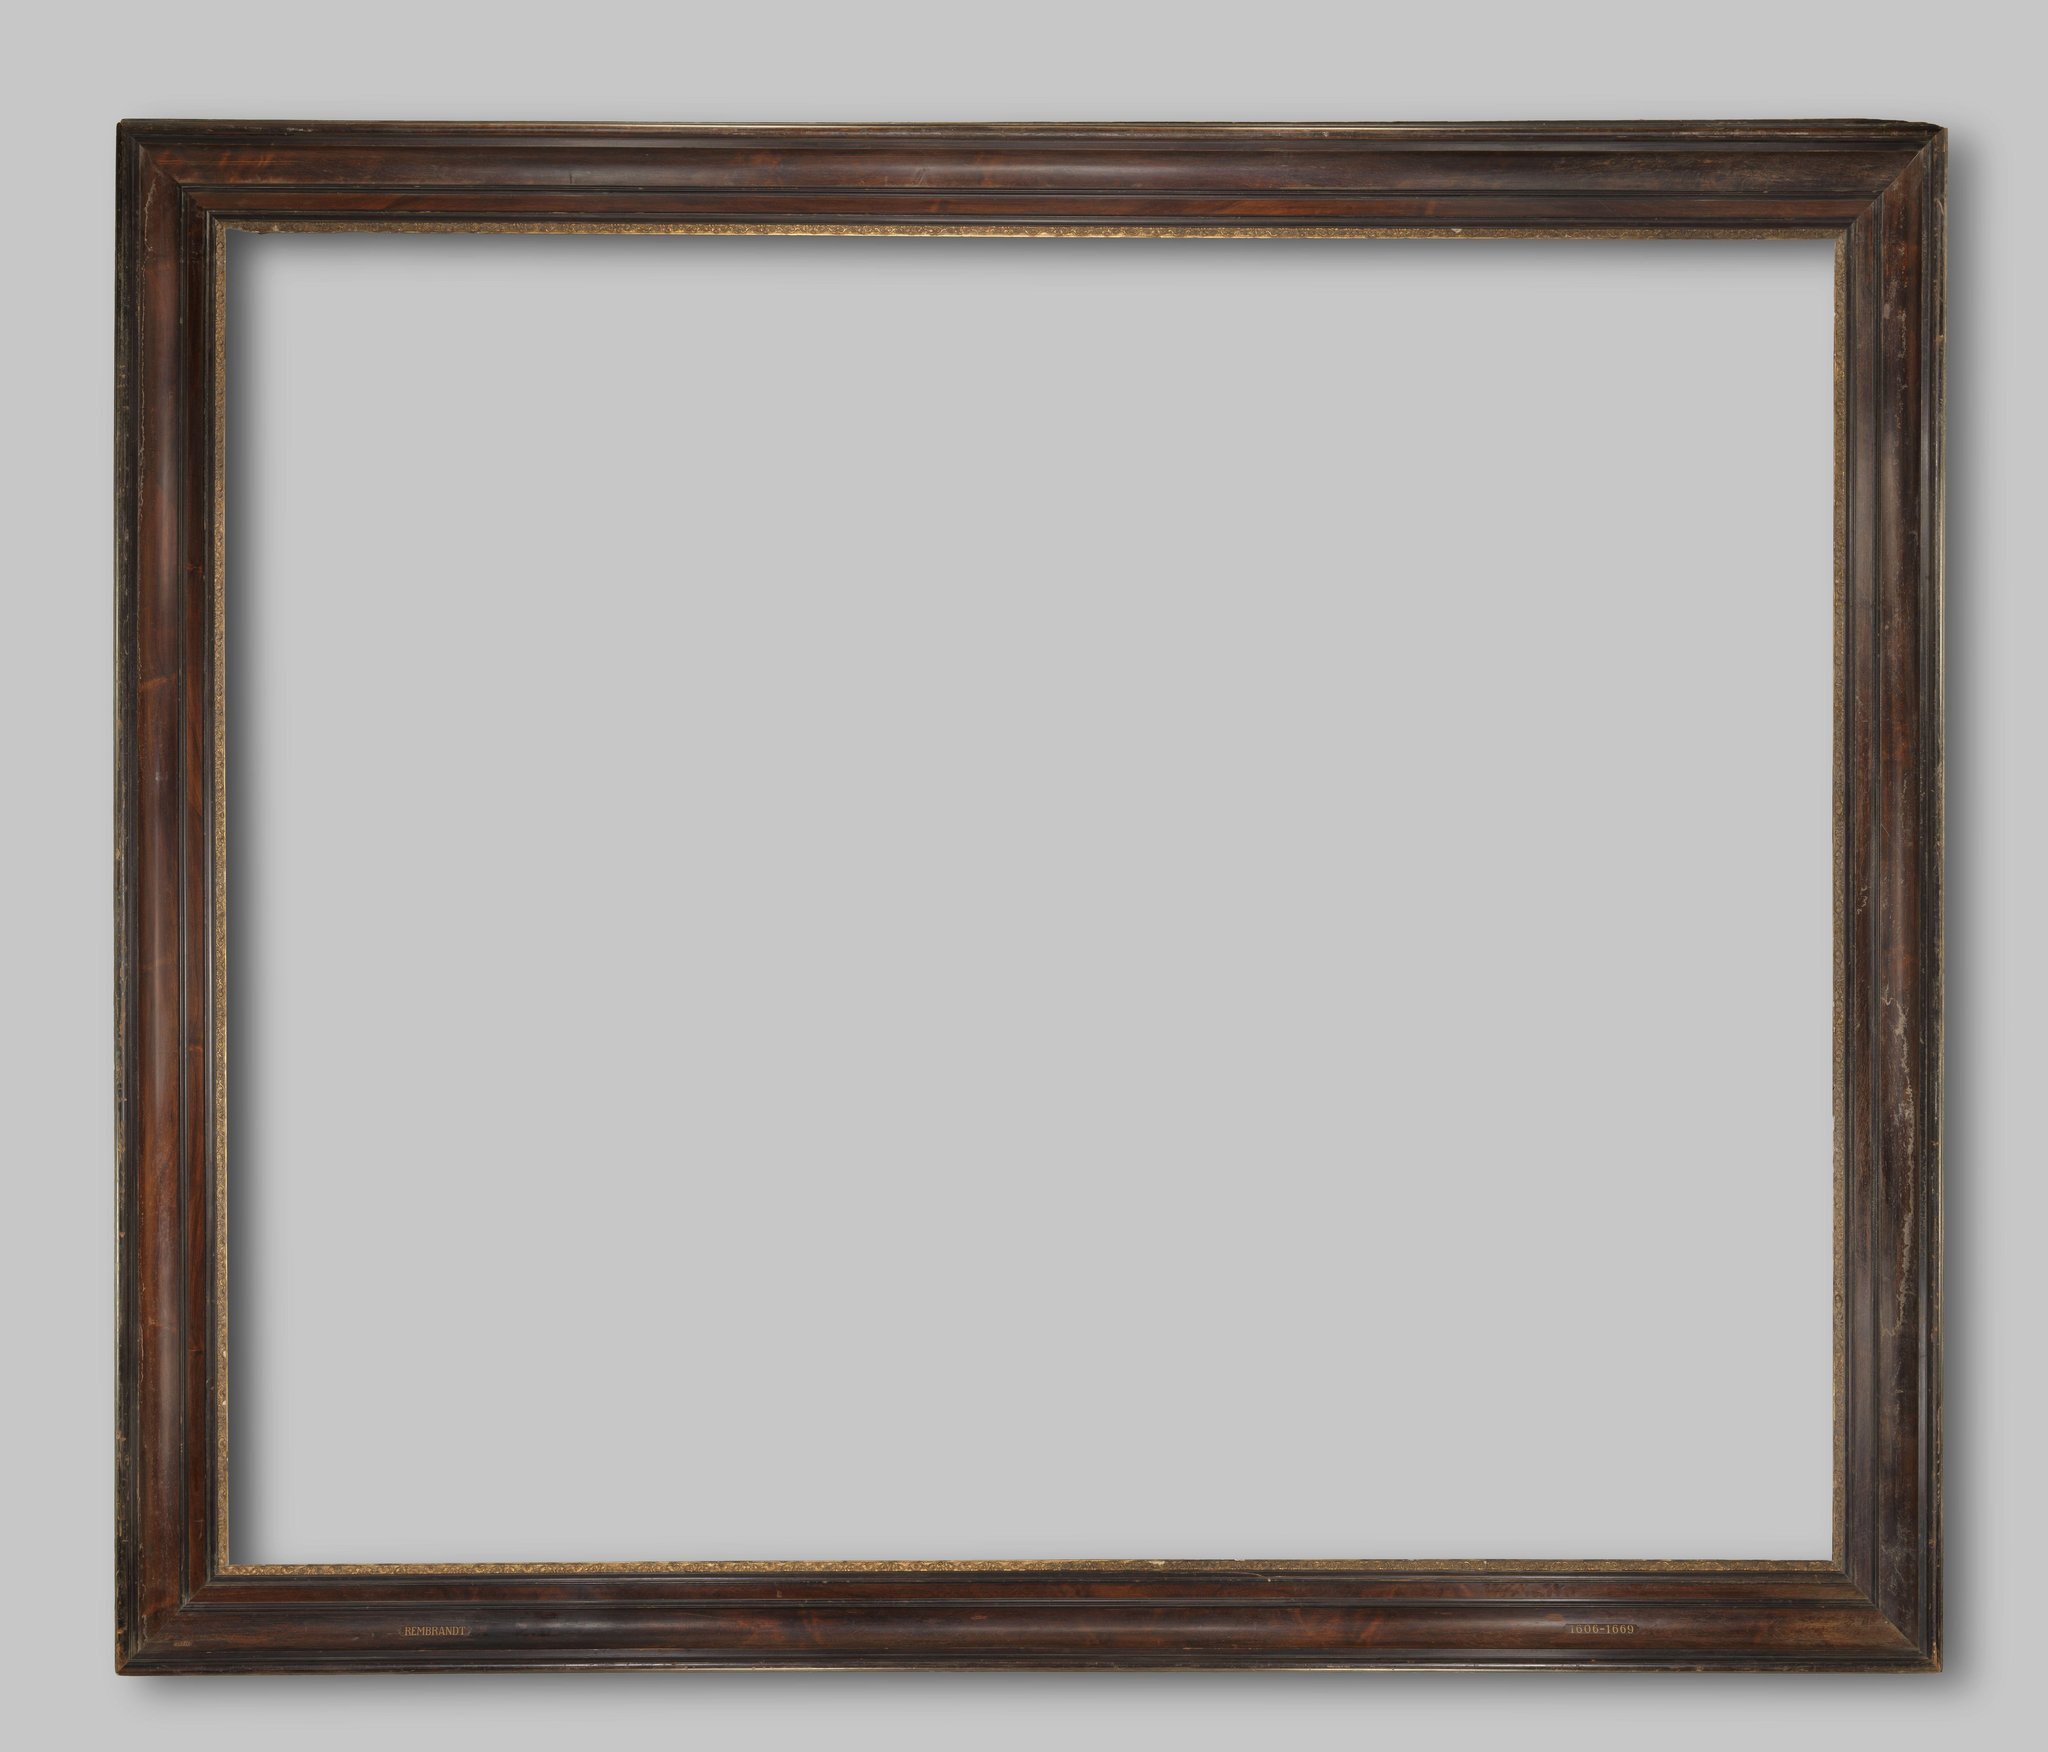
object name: frame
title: Bruine gebeitste profiellijst met vergulde binnenrand met pâte-ornamenten, 4 afzonderlijk genummerde delen.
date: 1600-1999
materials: gold leaf, wood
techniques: gilding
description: Houten profiellijst met een geornamenteerde en vergulde binnenrand.